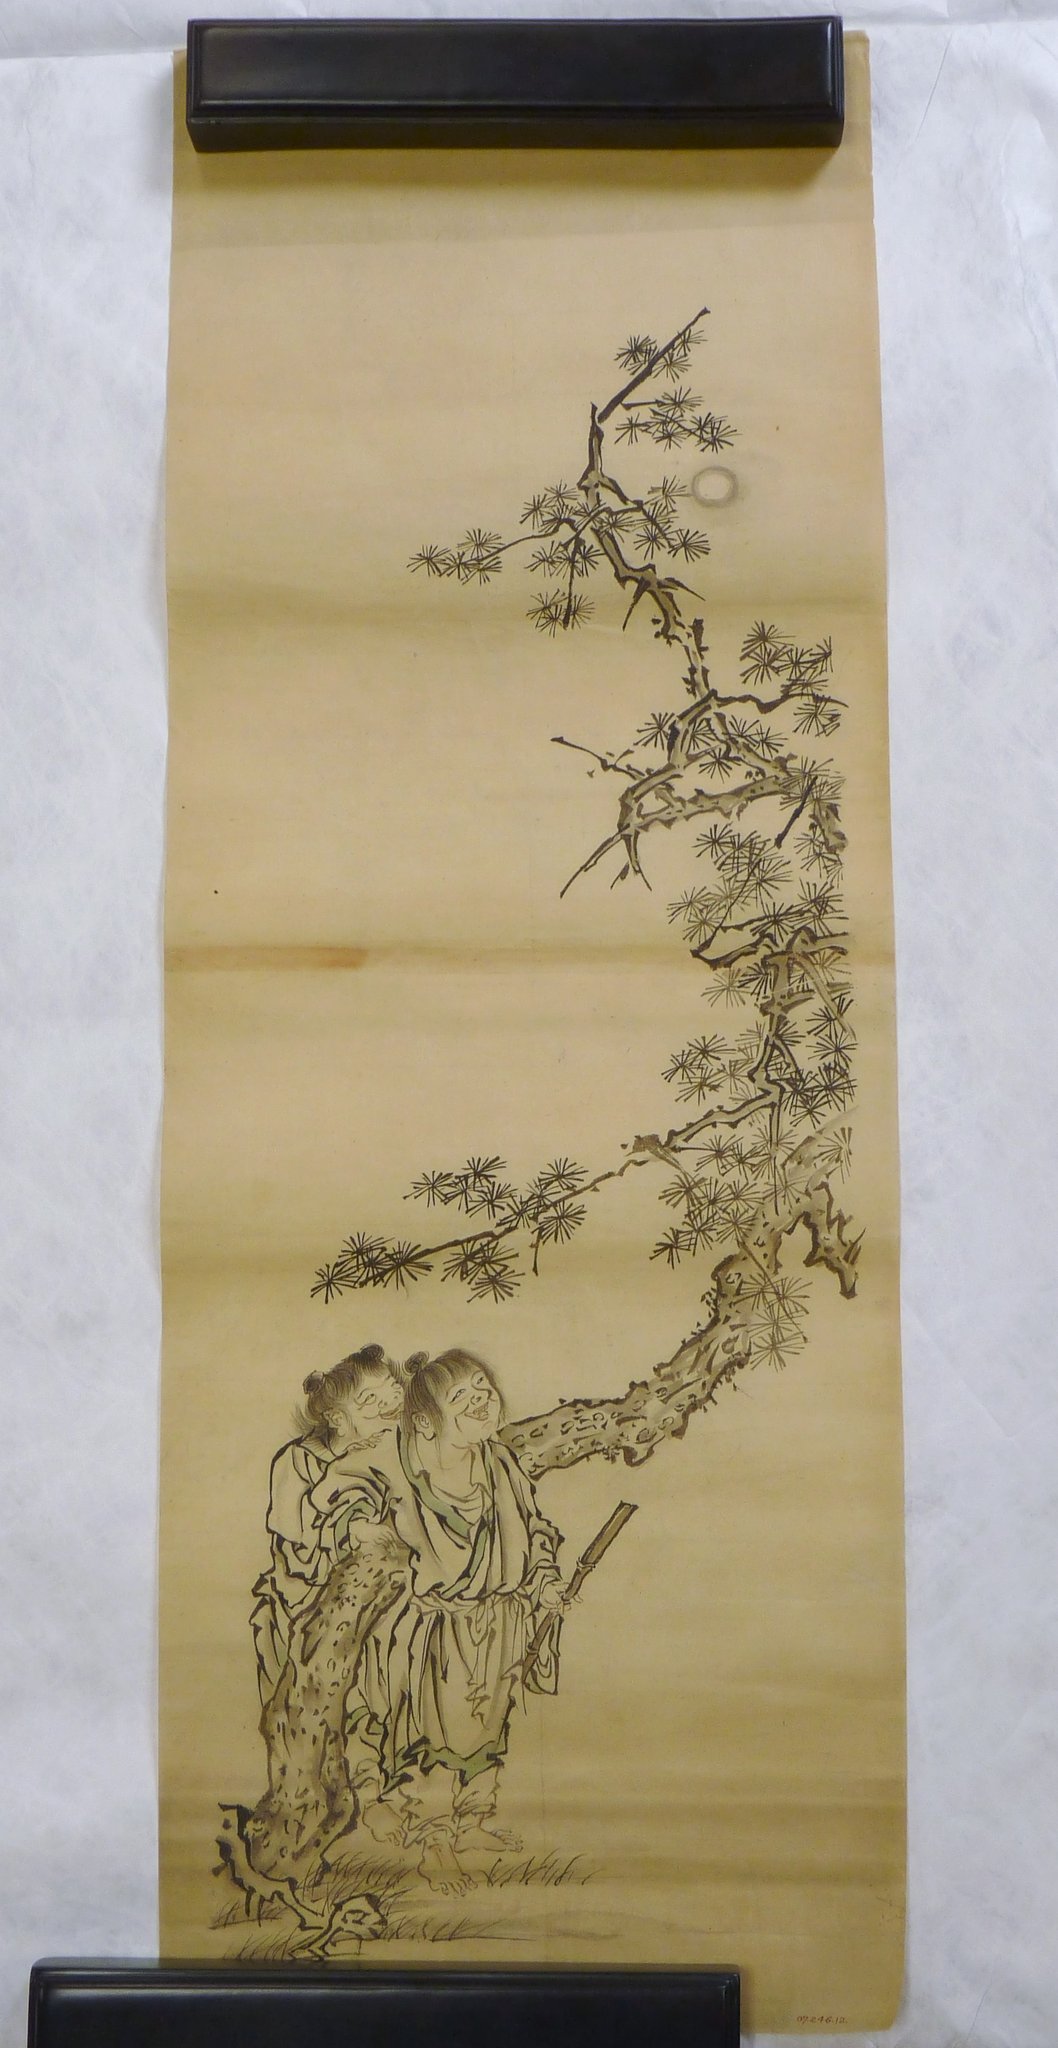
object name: drawing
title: Japanese Drawing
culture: japanese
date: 1801-1833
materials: paper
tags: human figures,trees